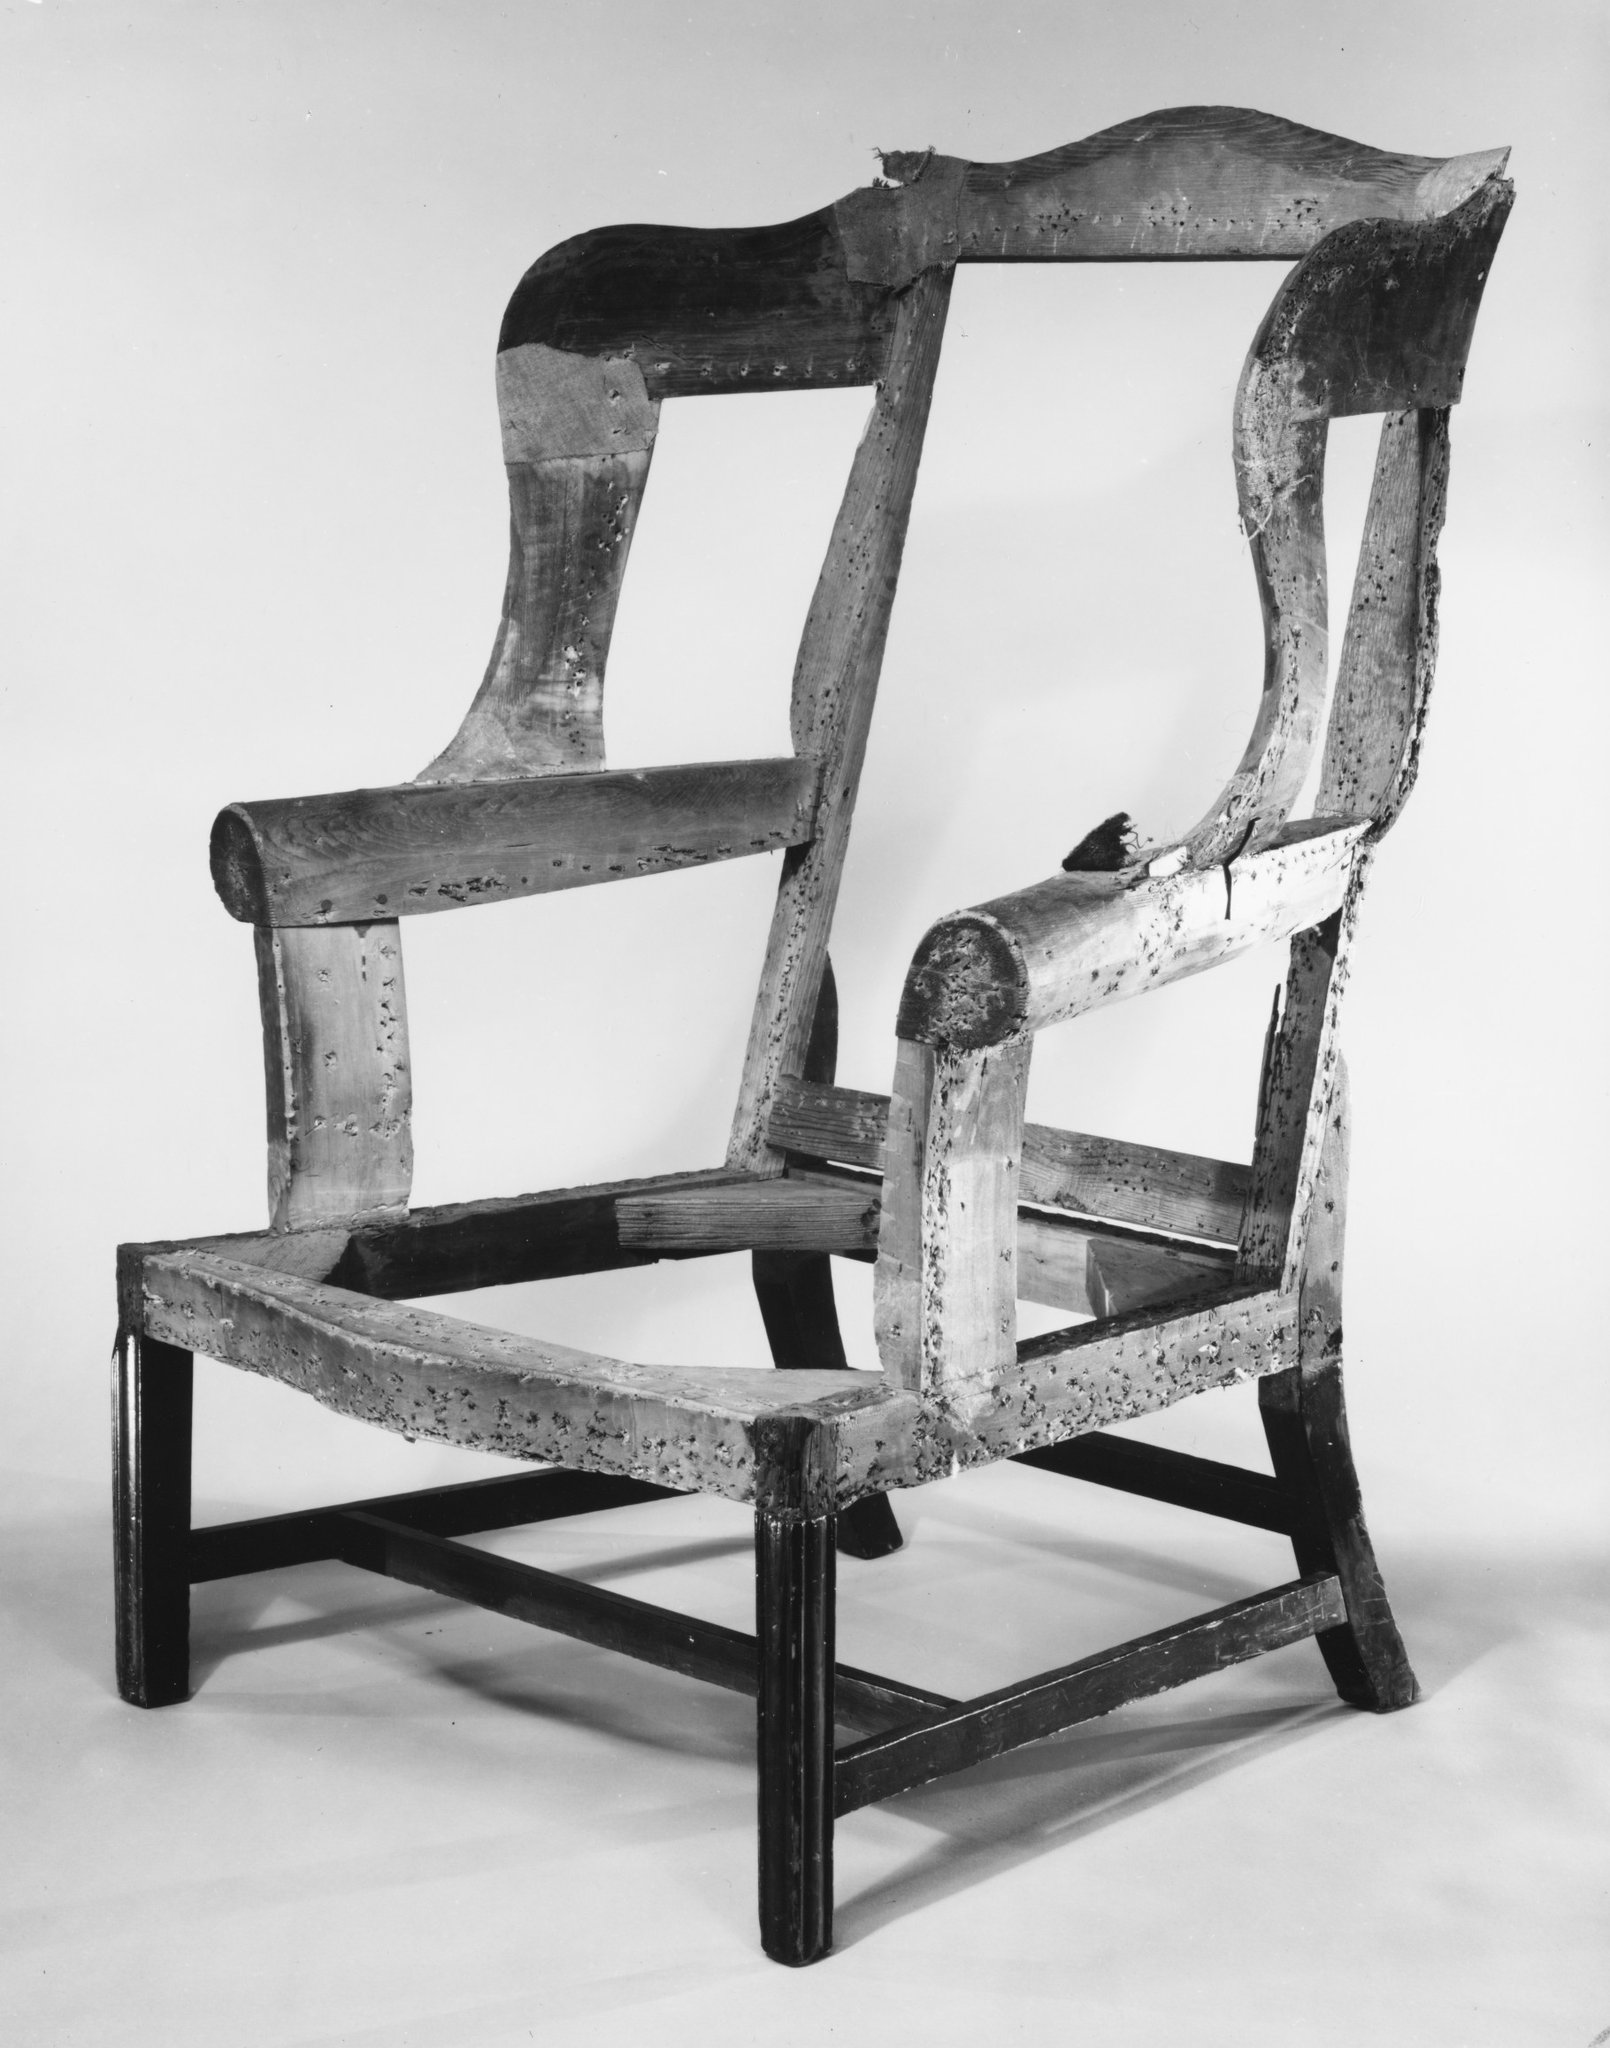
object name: easy chair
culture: american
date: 1790-1810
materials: wood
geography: united states